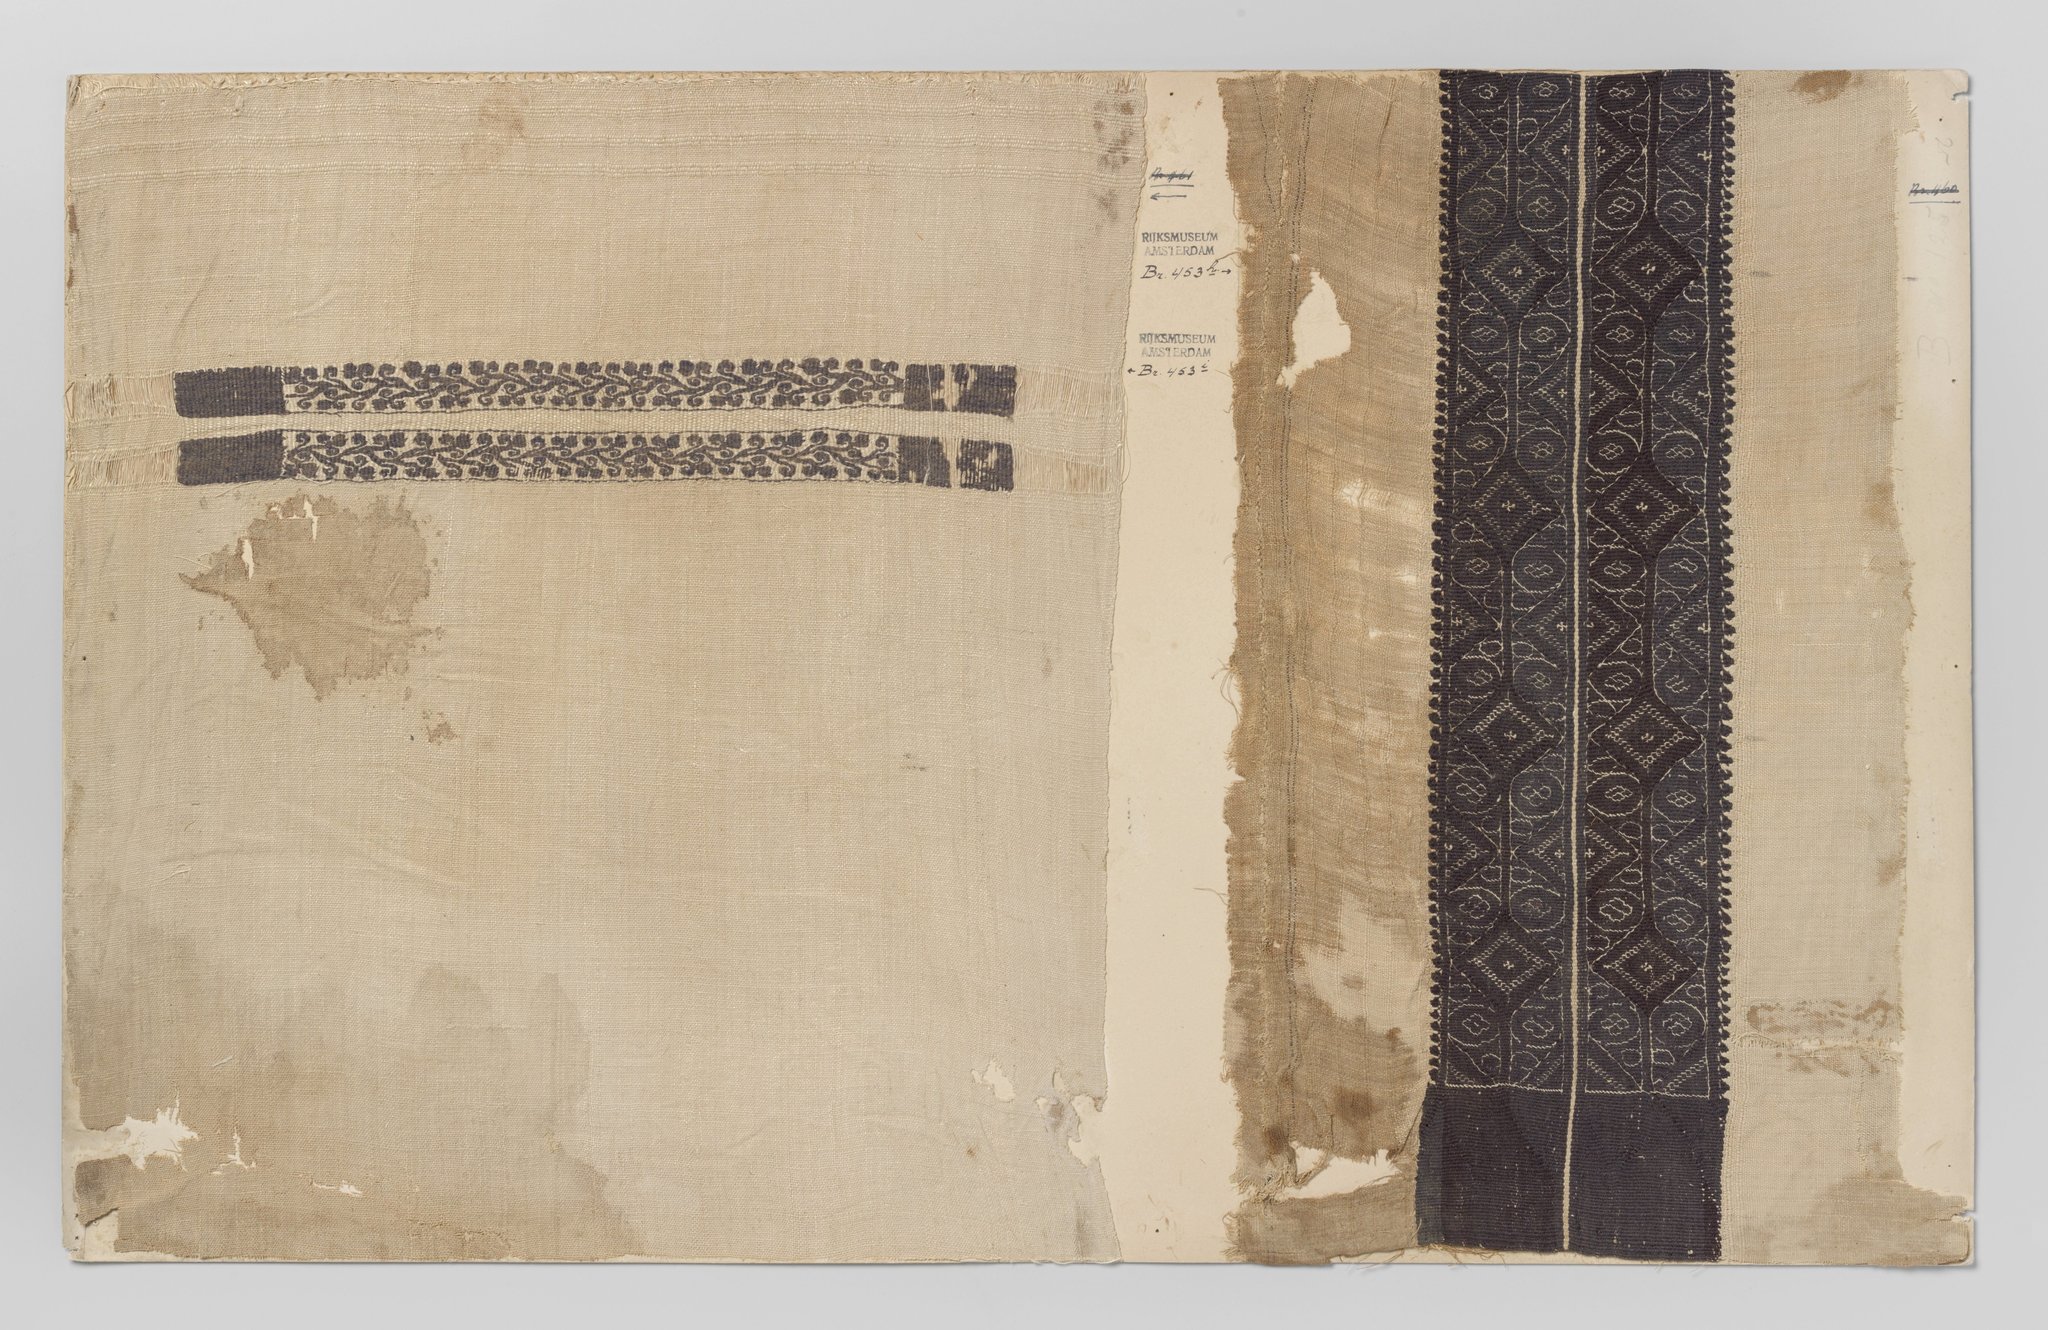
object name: fragment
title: Weefselfragment in tapijtwerk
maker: Anonymous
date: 200-399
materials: linen, wool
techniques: weave, tapestry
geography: egypt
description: Naturelkleurig linnen weefselfragment met twee donkerpaarse decoratieve banden met centraal ruiten met daarnaast driehoeken en cirkels met een vierpas. De buitenste randen hebben een parelmotief. Langs één lange zijde bevindt zich een naad met aangenaaide strook. Daarnaast lopen twee evenwijdige donkerblauwe inslagen.